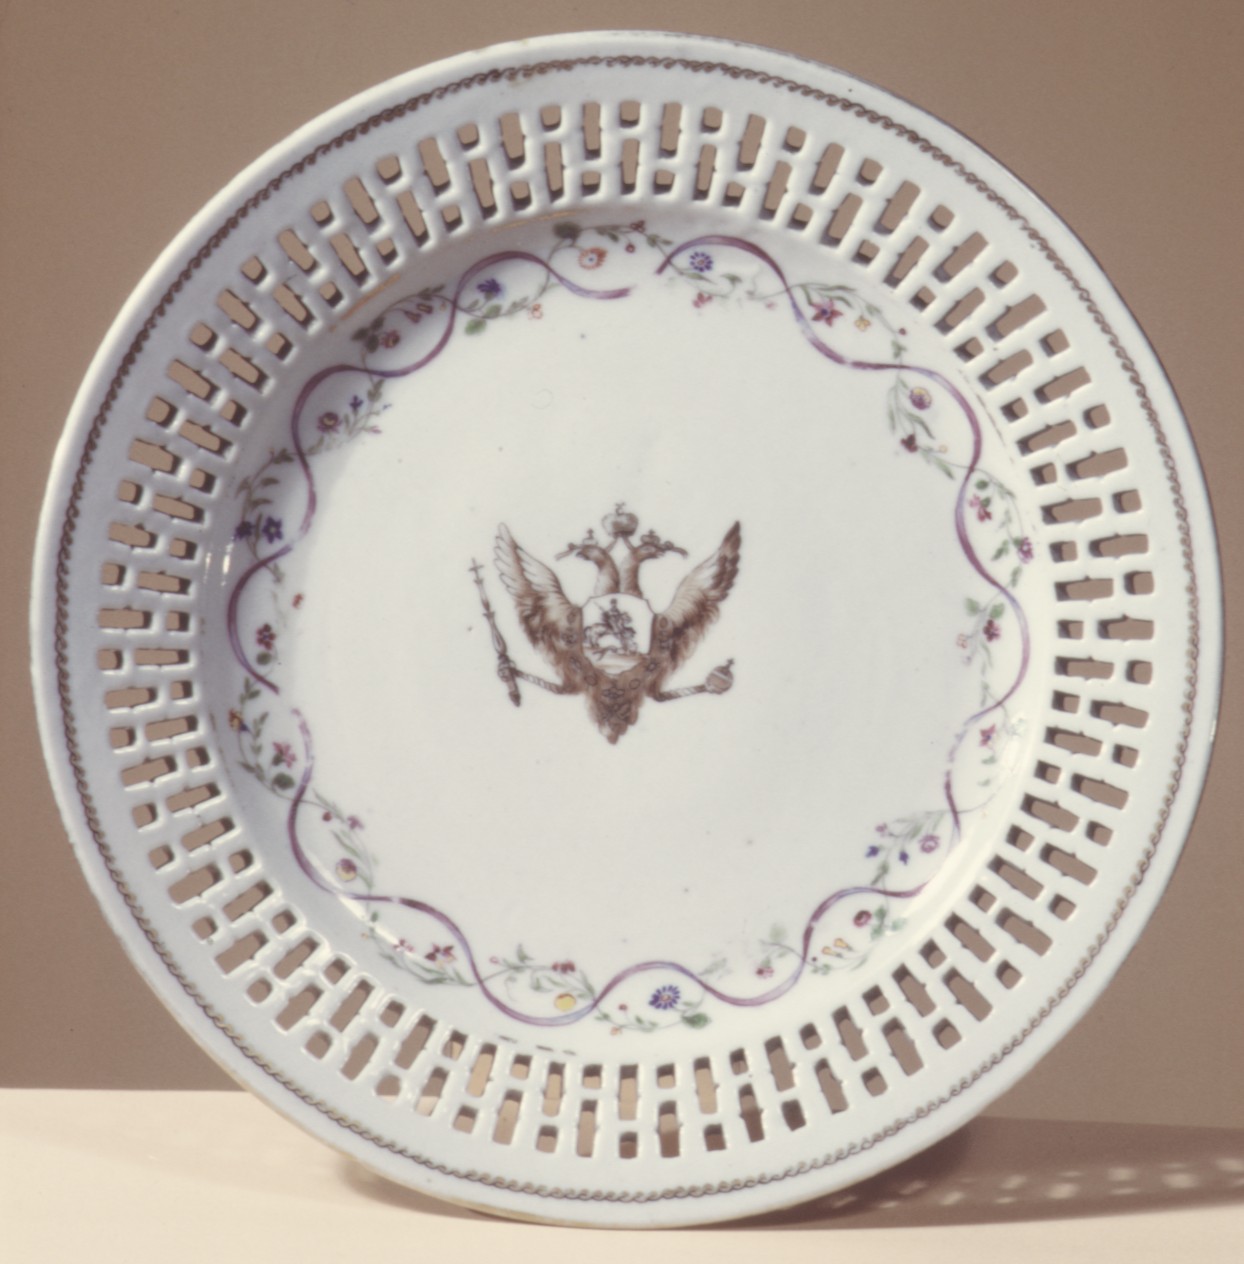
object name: plate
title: Plate (one of two)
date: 1780-1790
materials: hard paste porcelain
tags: birds,flowers,coat of arms